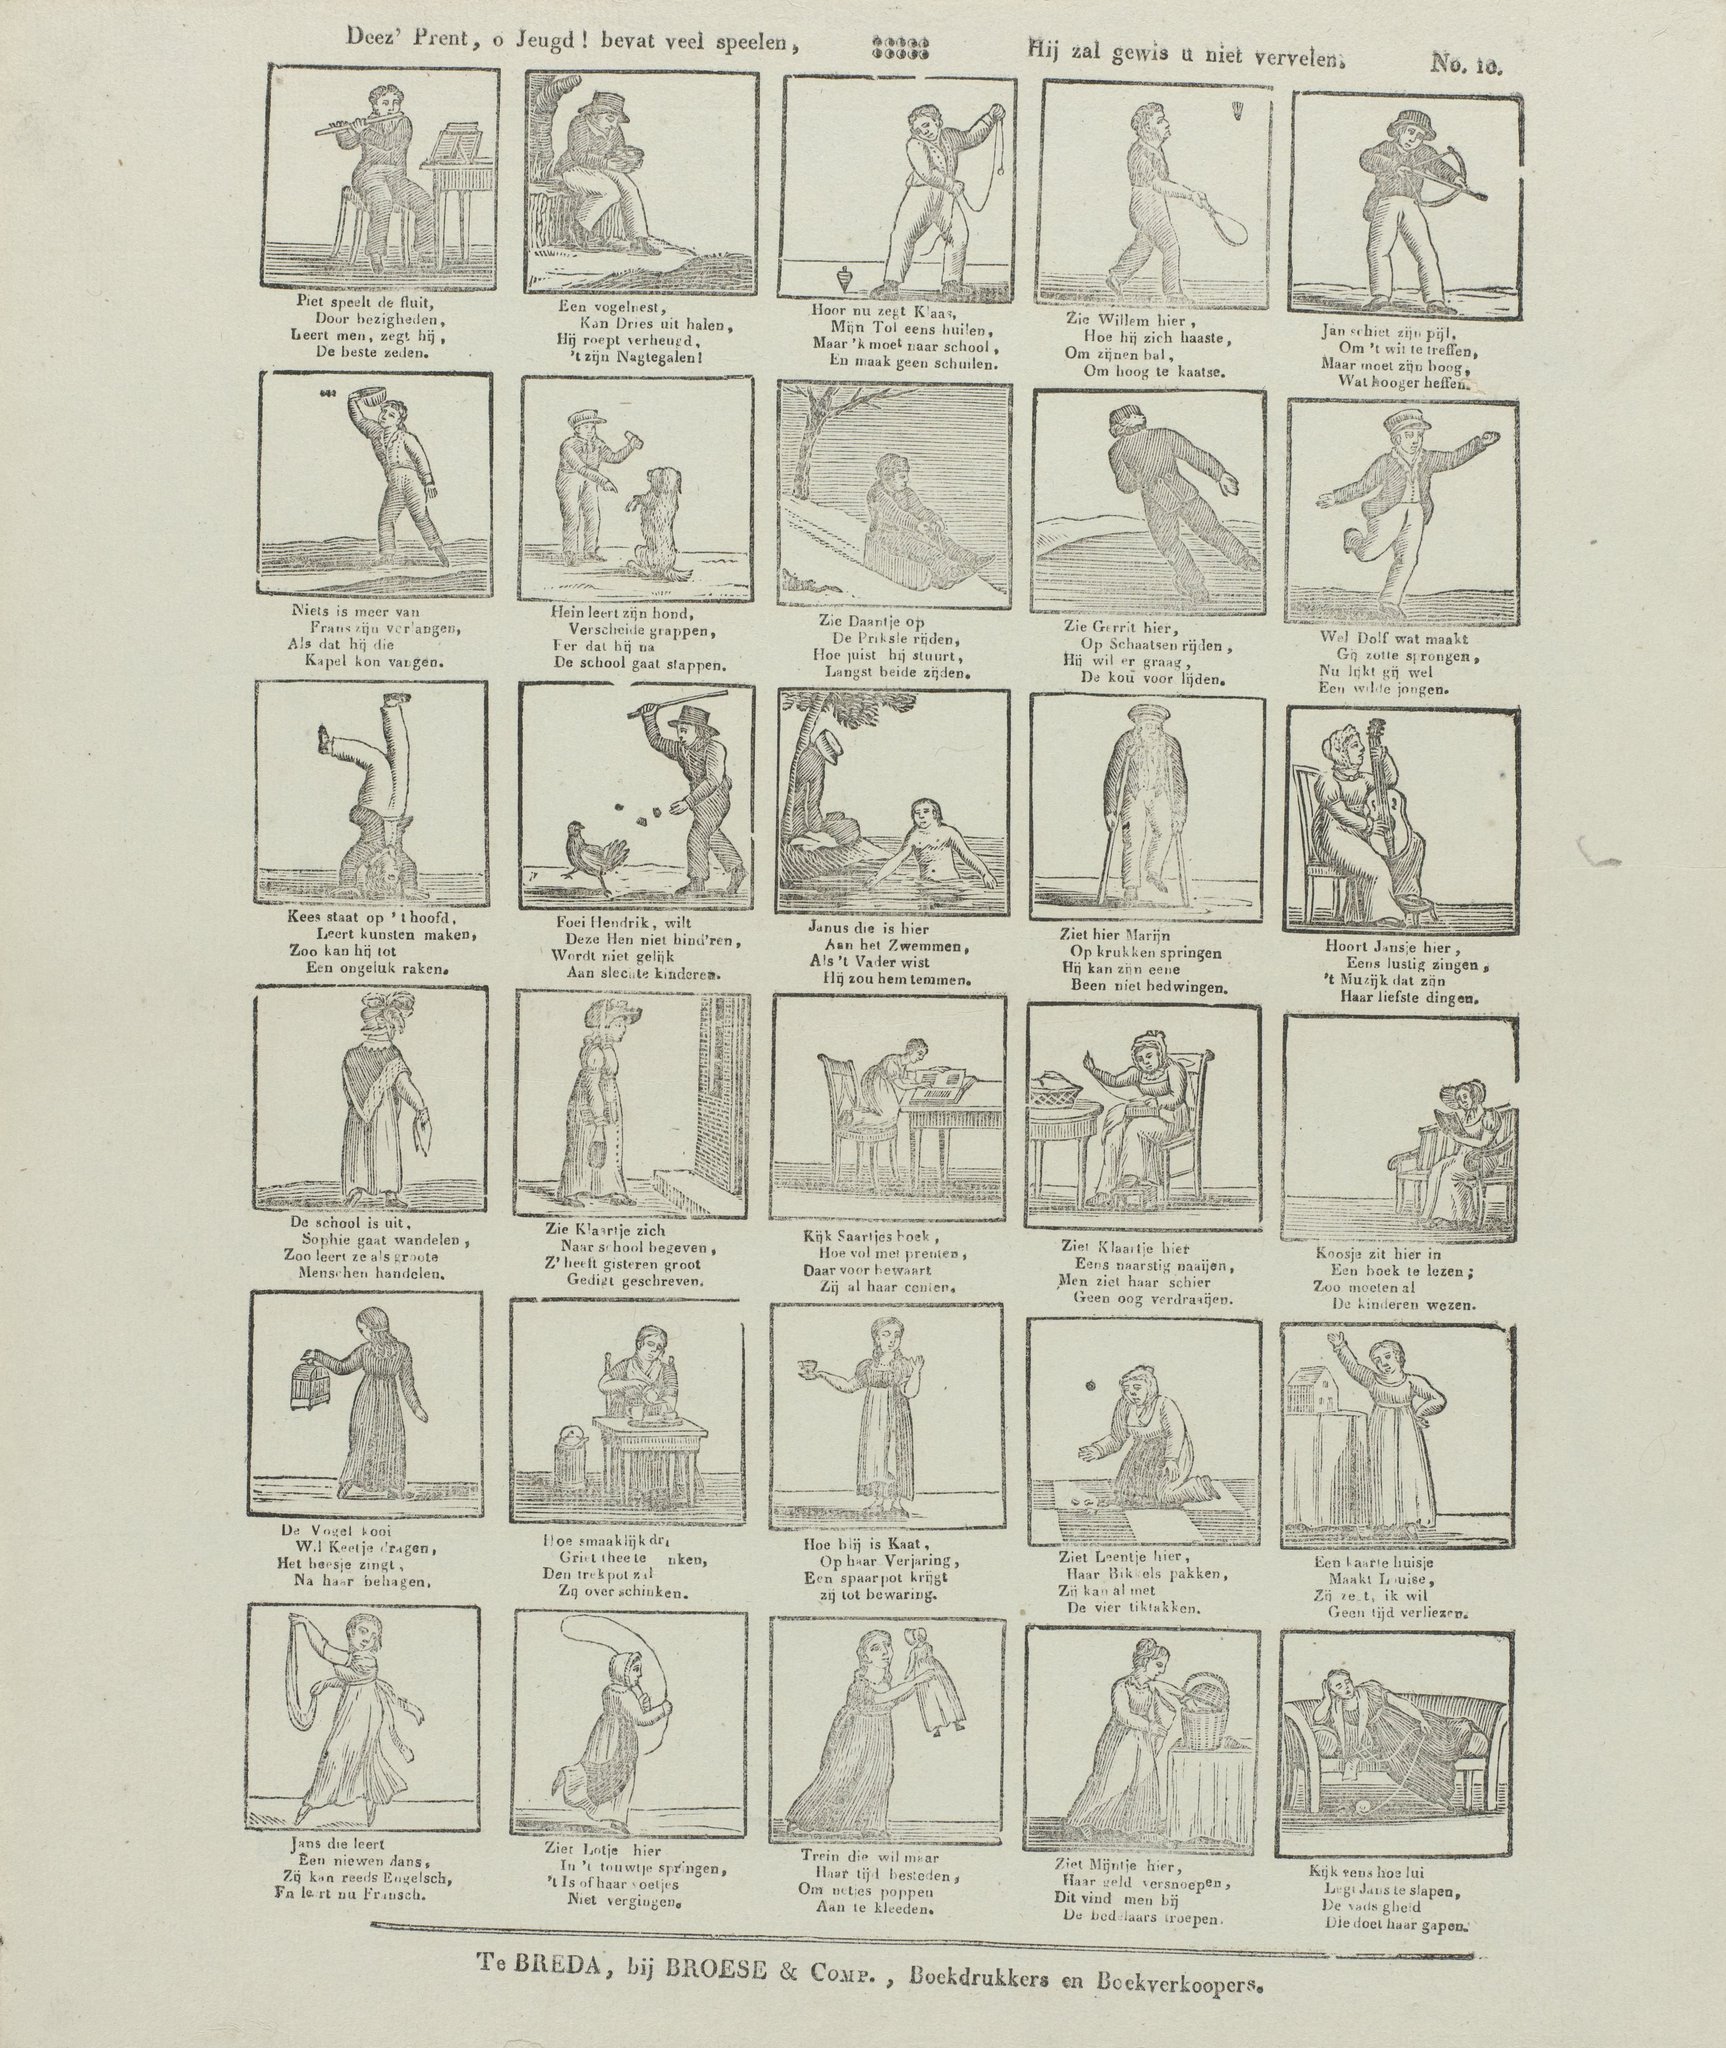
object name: print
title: Deez' prent, o jeugd! bevat veel speelen, / Hij zal gewis u niet vervelen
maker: Anonymous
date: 1828-1853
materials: paper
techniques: letterpress printing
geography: breda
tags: children's games and plays, games using special objects (marbles, top, hoop, etc.)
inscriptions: collector's mark: Lugt 2760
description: Blad met 30 voorstellingen van kinderspelen, waaronder fluit spelen, tollen, op het hoofd staan en een kaartenhuis bouwen. Onder elke voorstelling een vierregelig vers. Genummerd rechtsboven: No. 10.